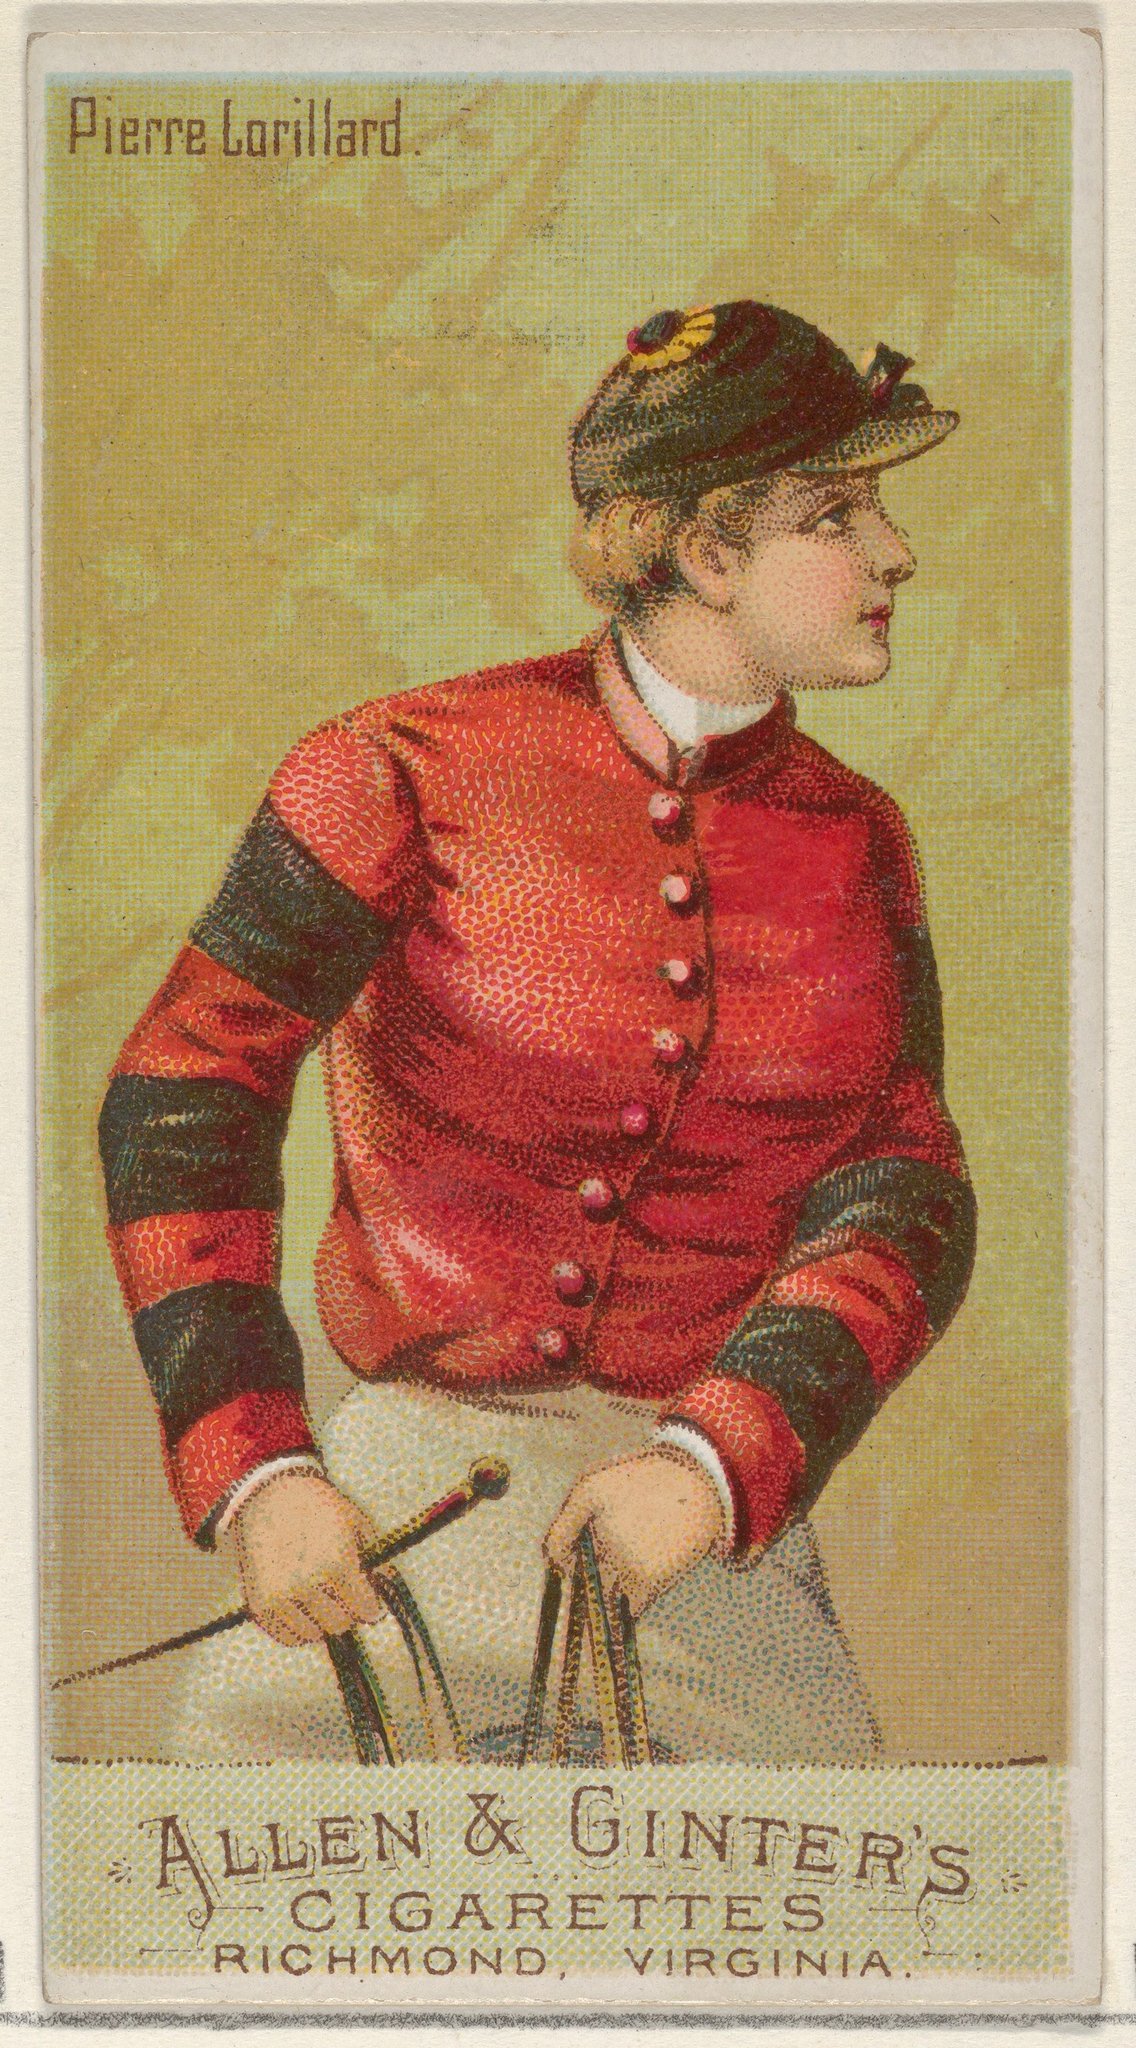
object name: print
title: Pierre Lorillard, from the Racing Colors of the World series (N22a) for Allen & Ginter Cigarettes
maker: allen & ginter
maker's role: publisher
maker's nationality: american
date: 1888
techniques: color lithograph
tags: women,jockeys